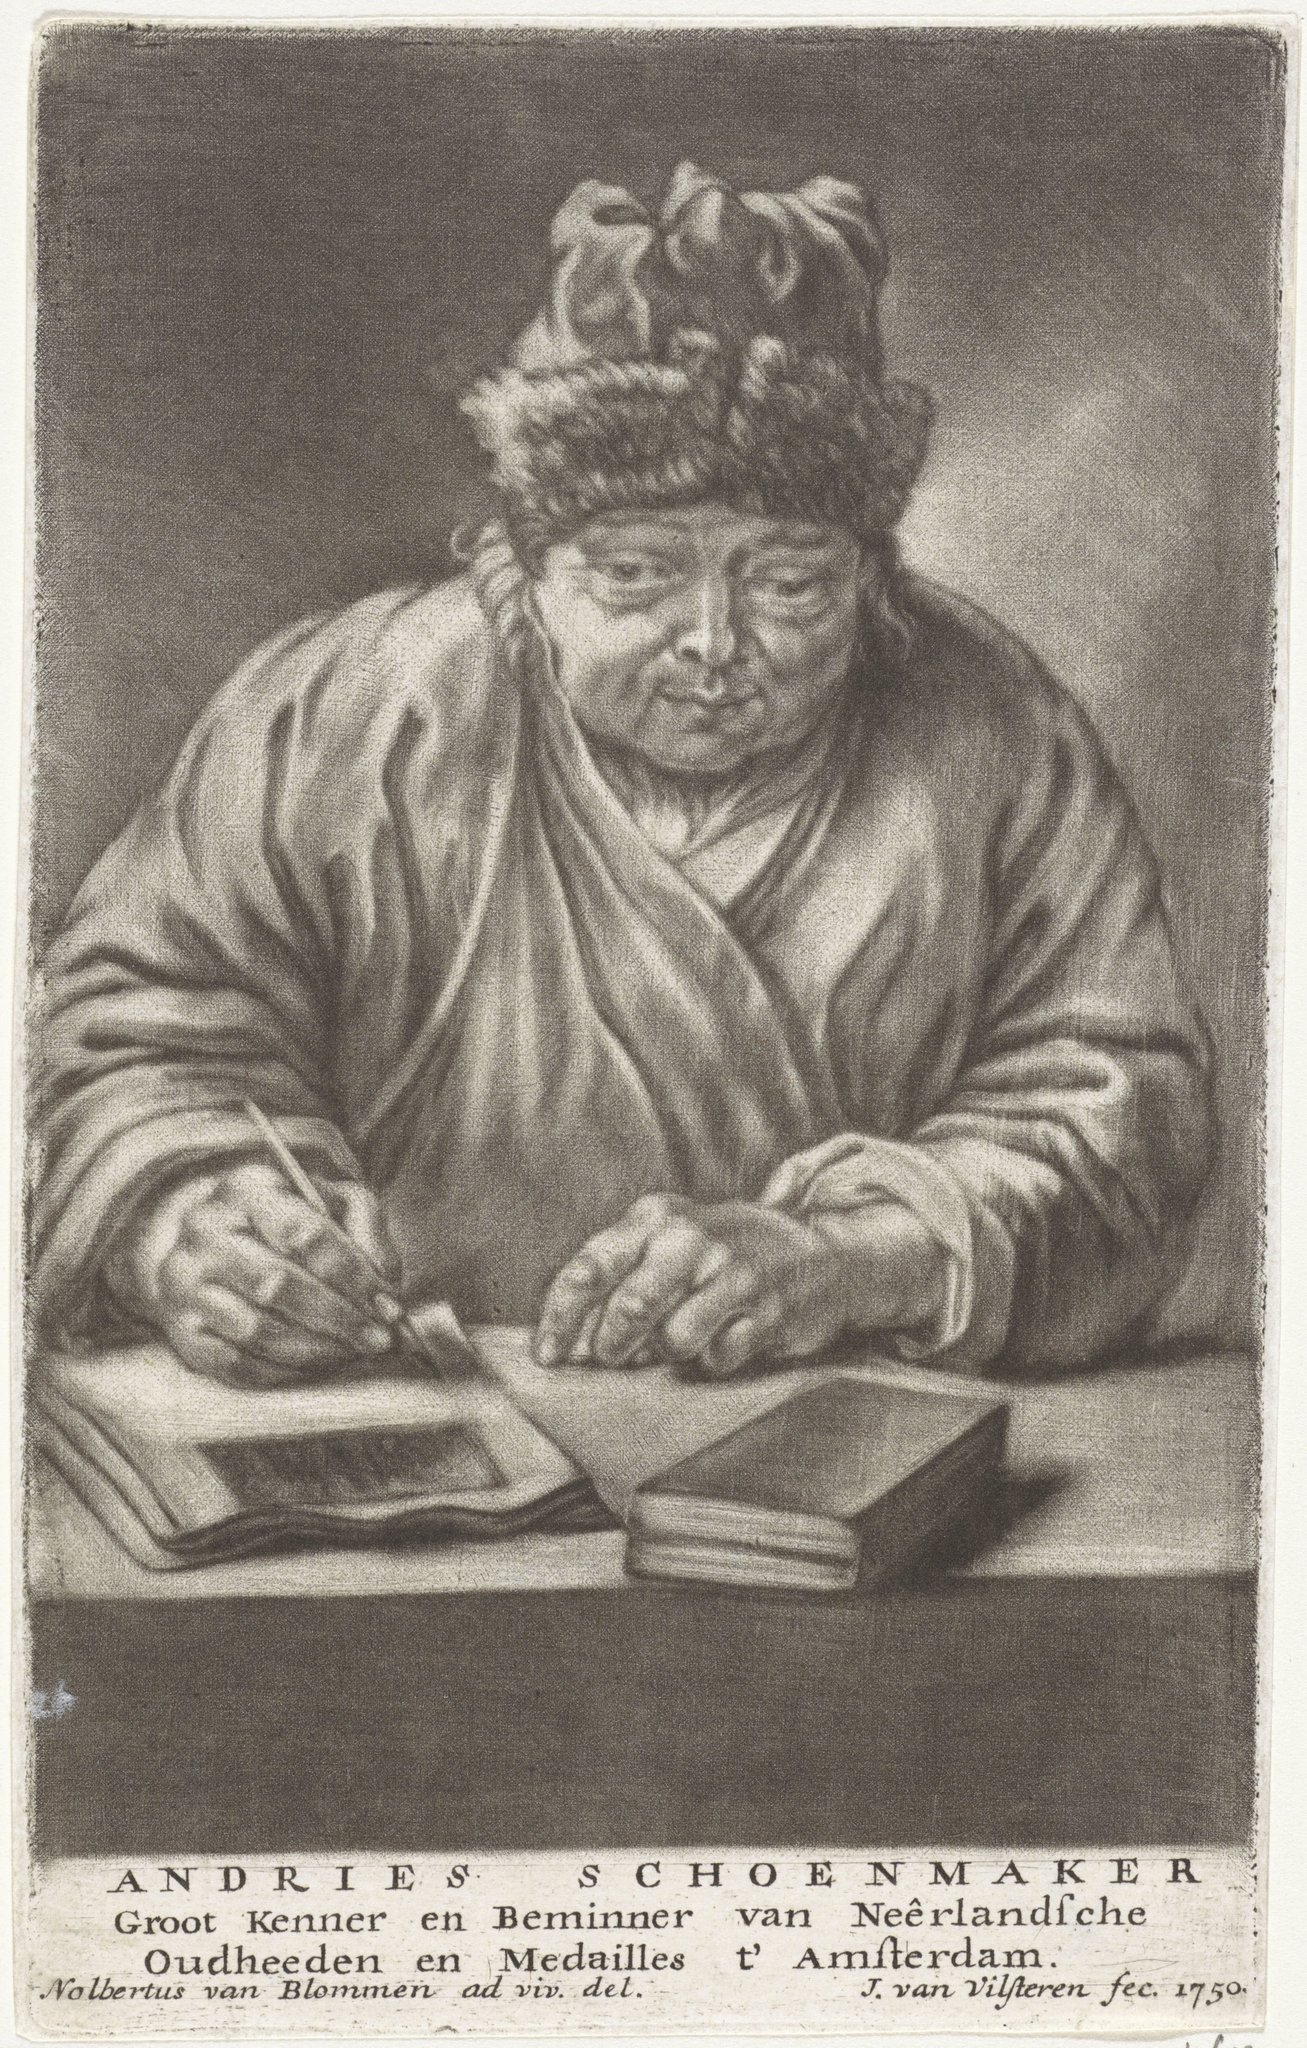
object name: print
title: Portret van Andries Schoemaker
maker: johannes van vilsteren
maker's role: print maker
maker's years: -1763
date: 1750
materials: paper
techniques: mezzotint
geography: northern netherlands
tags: amsterdam, draughtsman, andries schoemaker, drawing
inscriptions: collector's mark: Lugt 2228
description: De kunstminnaar en tekenaar Andries Schoemaker zit aan een bureau te tekenen.